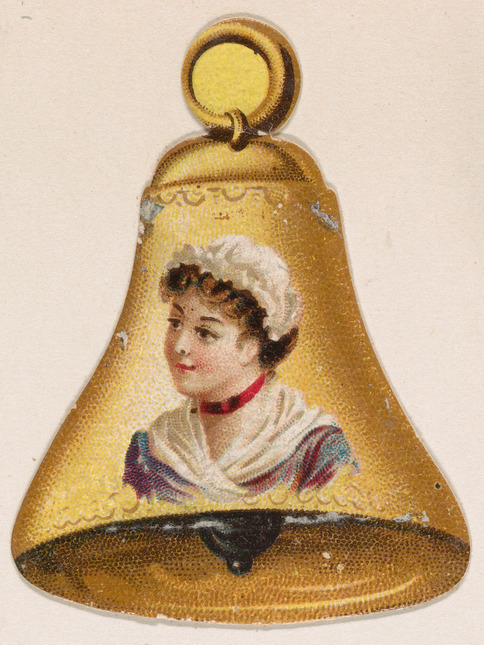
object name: print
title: Bell, from the Novelties series (N228, Type 3) issued by Kinney Bros.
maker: kinney brothers tobacco company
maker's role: publisher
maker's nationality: american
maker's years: 1869-2011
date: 1889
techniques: color lithograph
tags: musical instruments,women